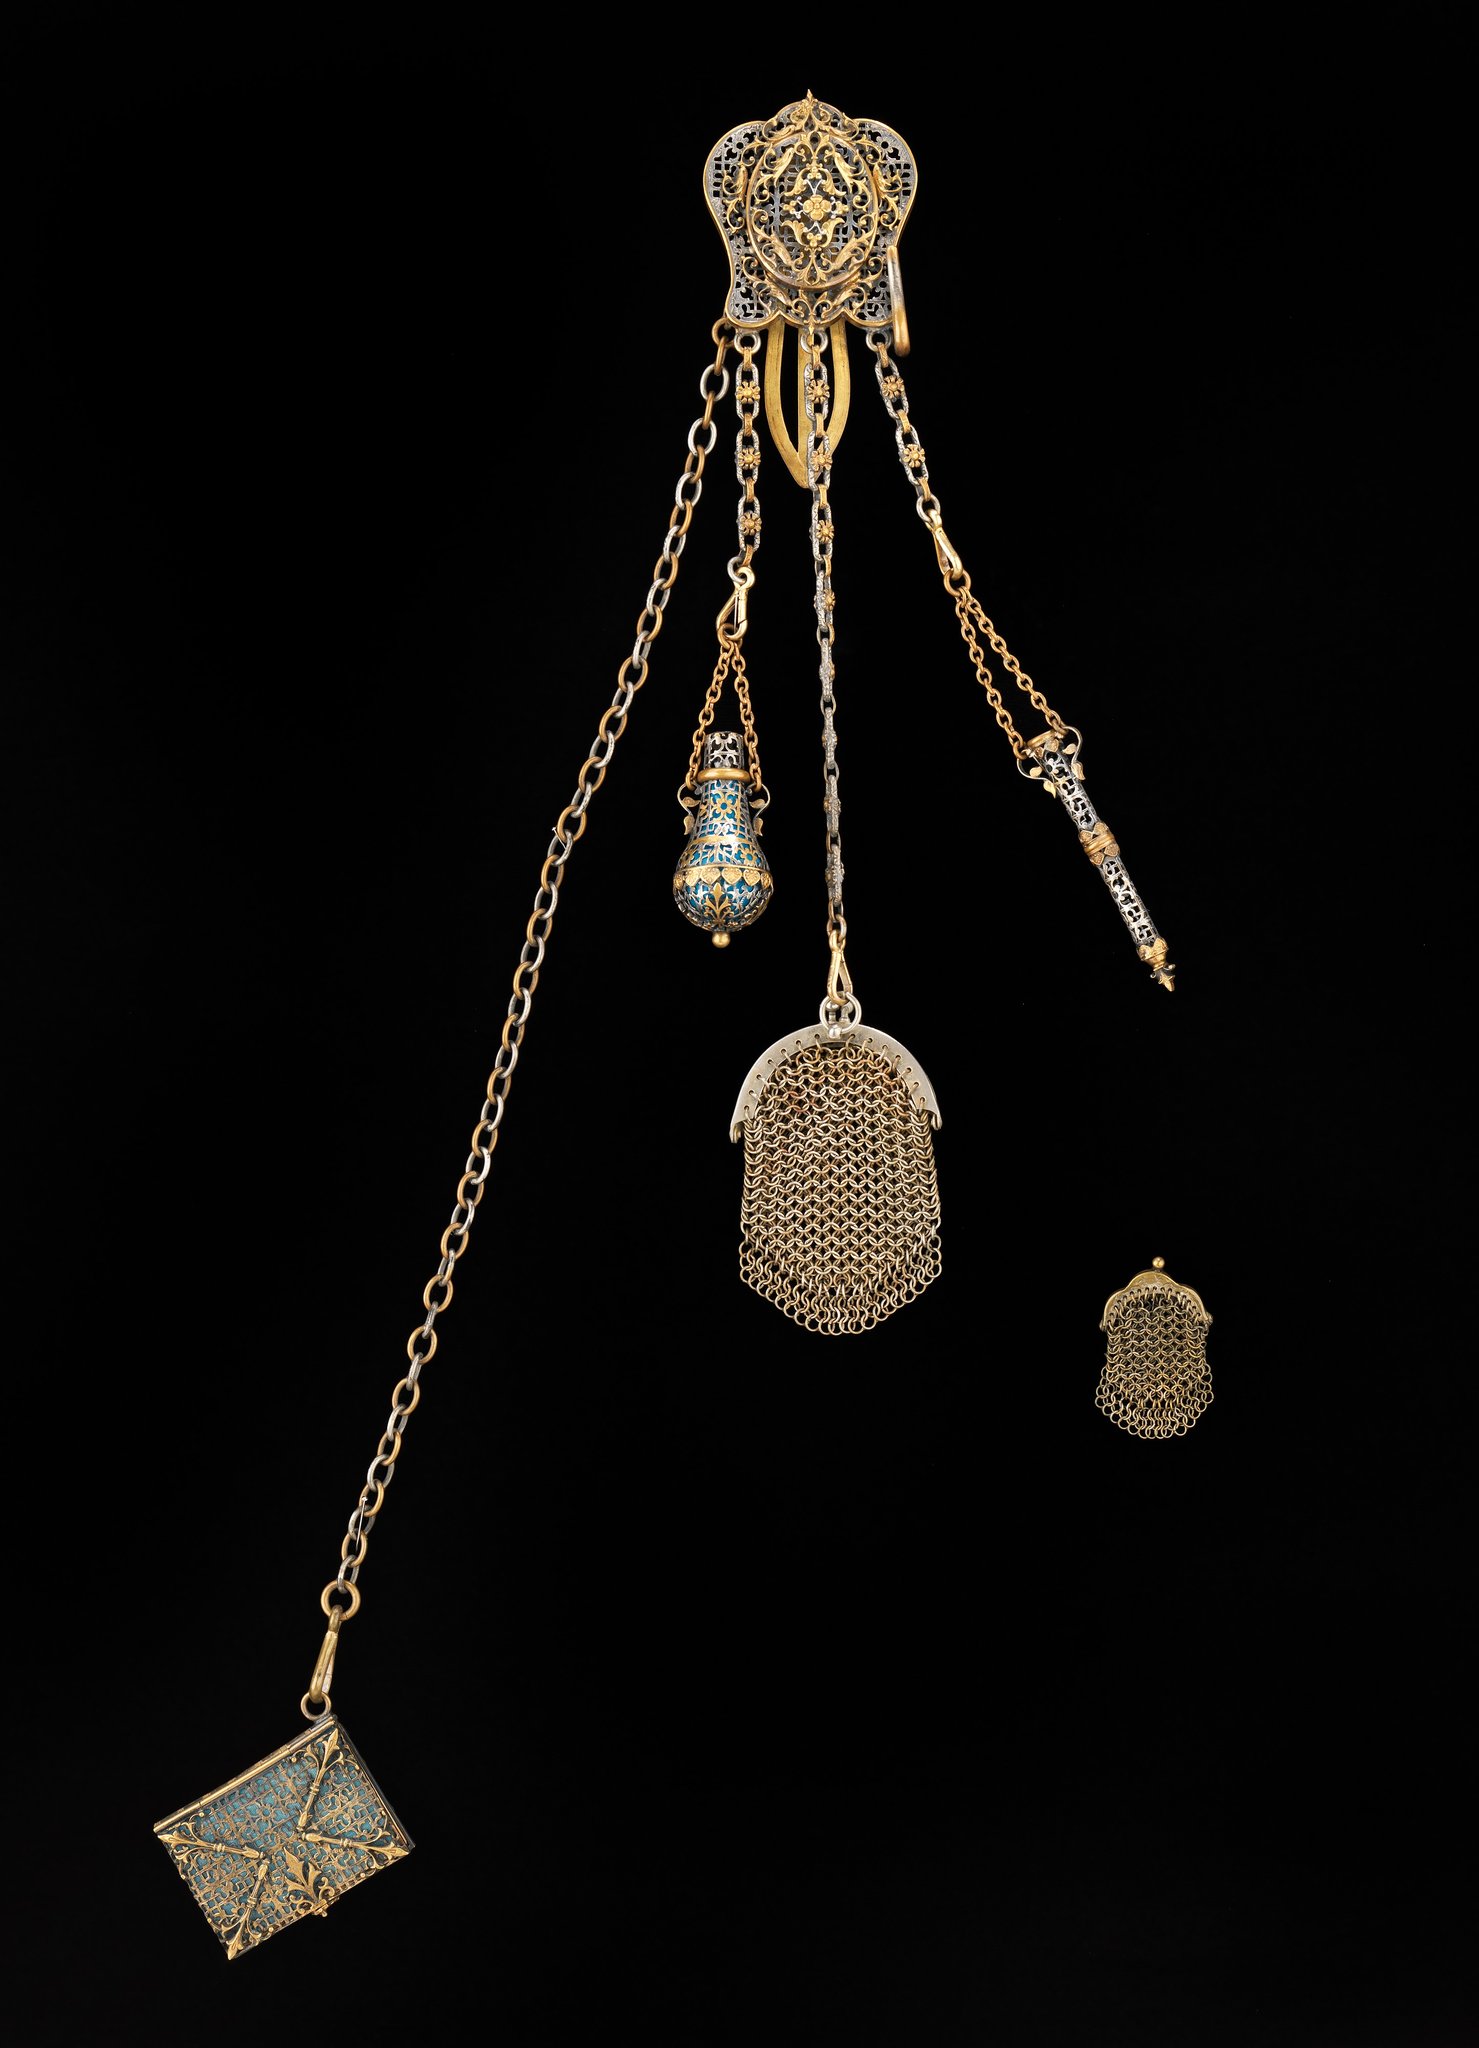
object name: chatelaine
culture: french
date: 1876-1900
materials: enamel, metal, paper